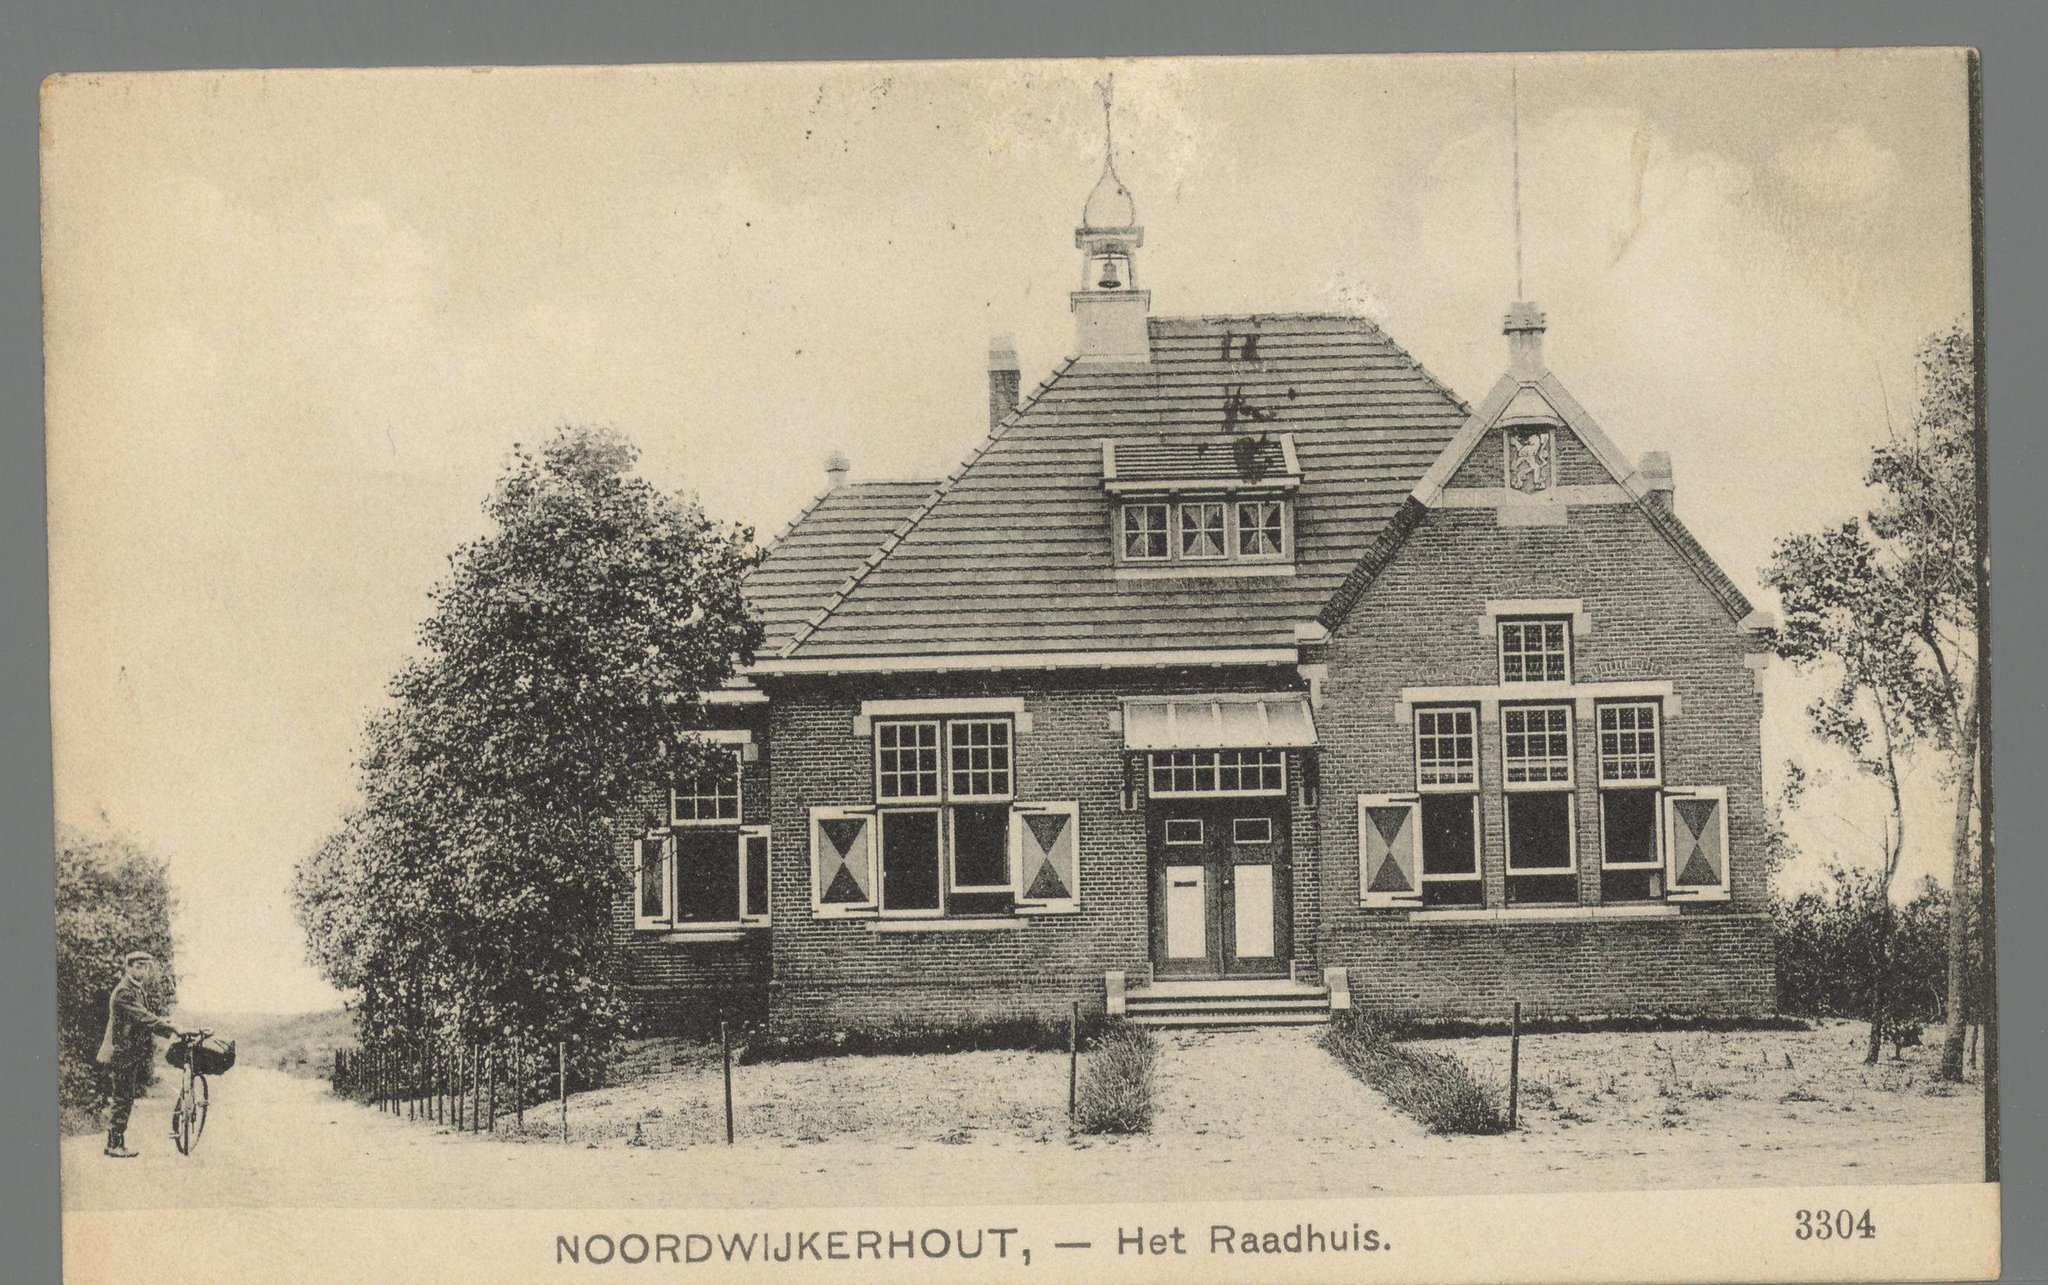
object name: ansichtkaart, prentbriefkaart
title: Noordwijkerhout, - Het Raadhuis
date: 1905-1910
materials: cardboard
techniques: photograph, writing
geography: noordwijkerhout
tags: townhall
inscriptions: postage stamp